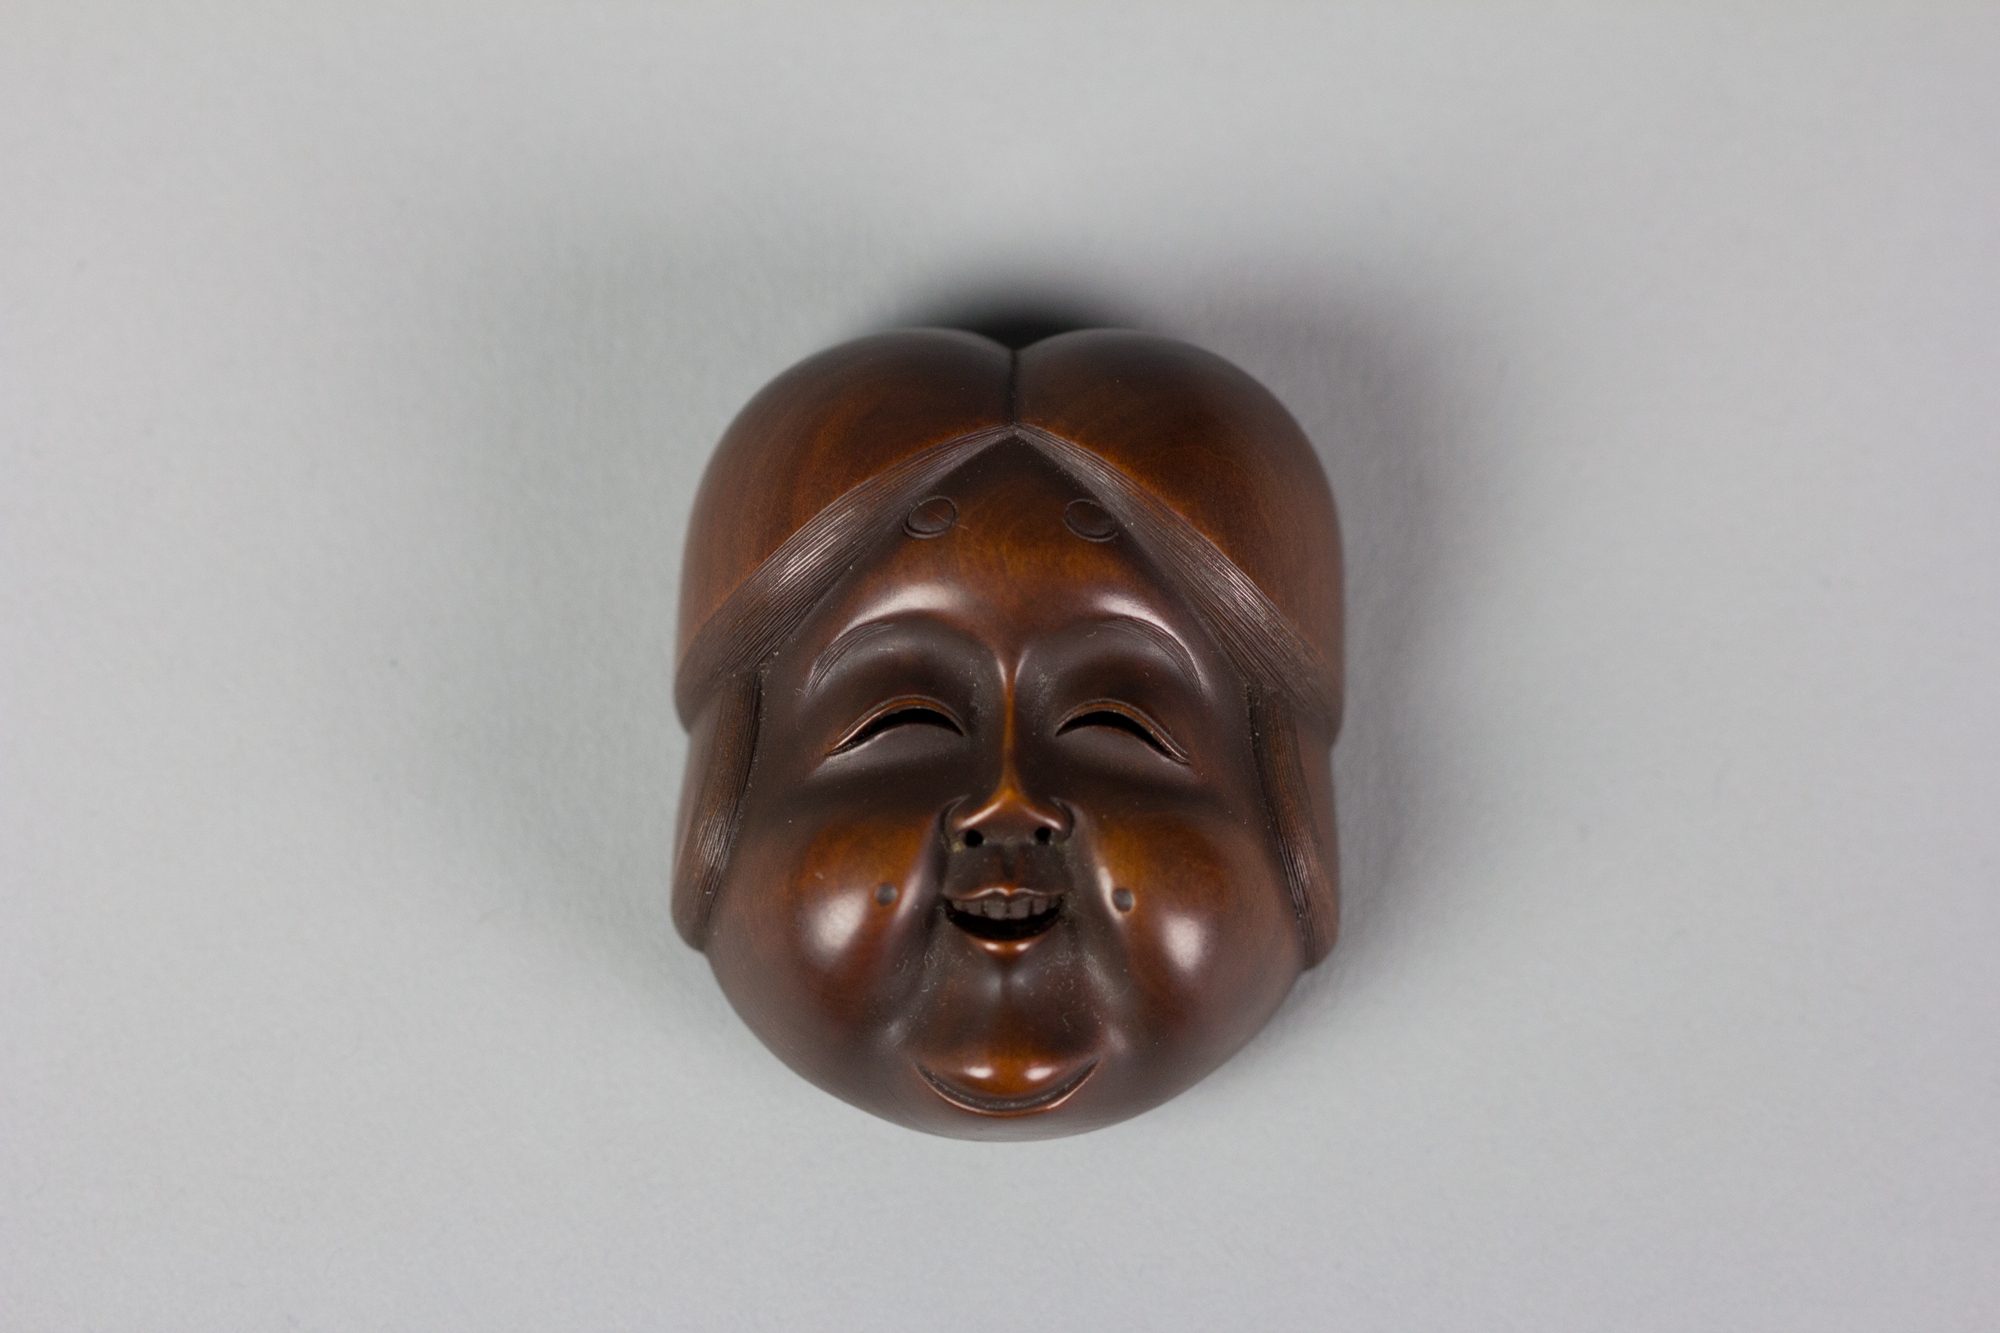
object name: netsuke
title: Netsuke of Noh mask; Face of Usume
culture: japanese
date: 1801-1900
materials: wood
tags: masks